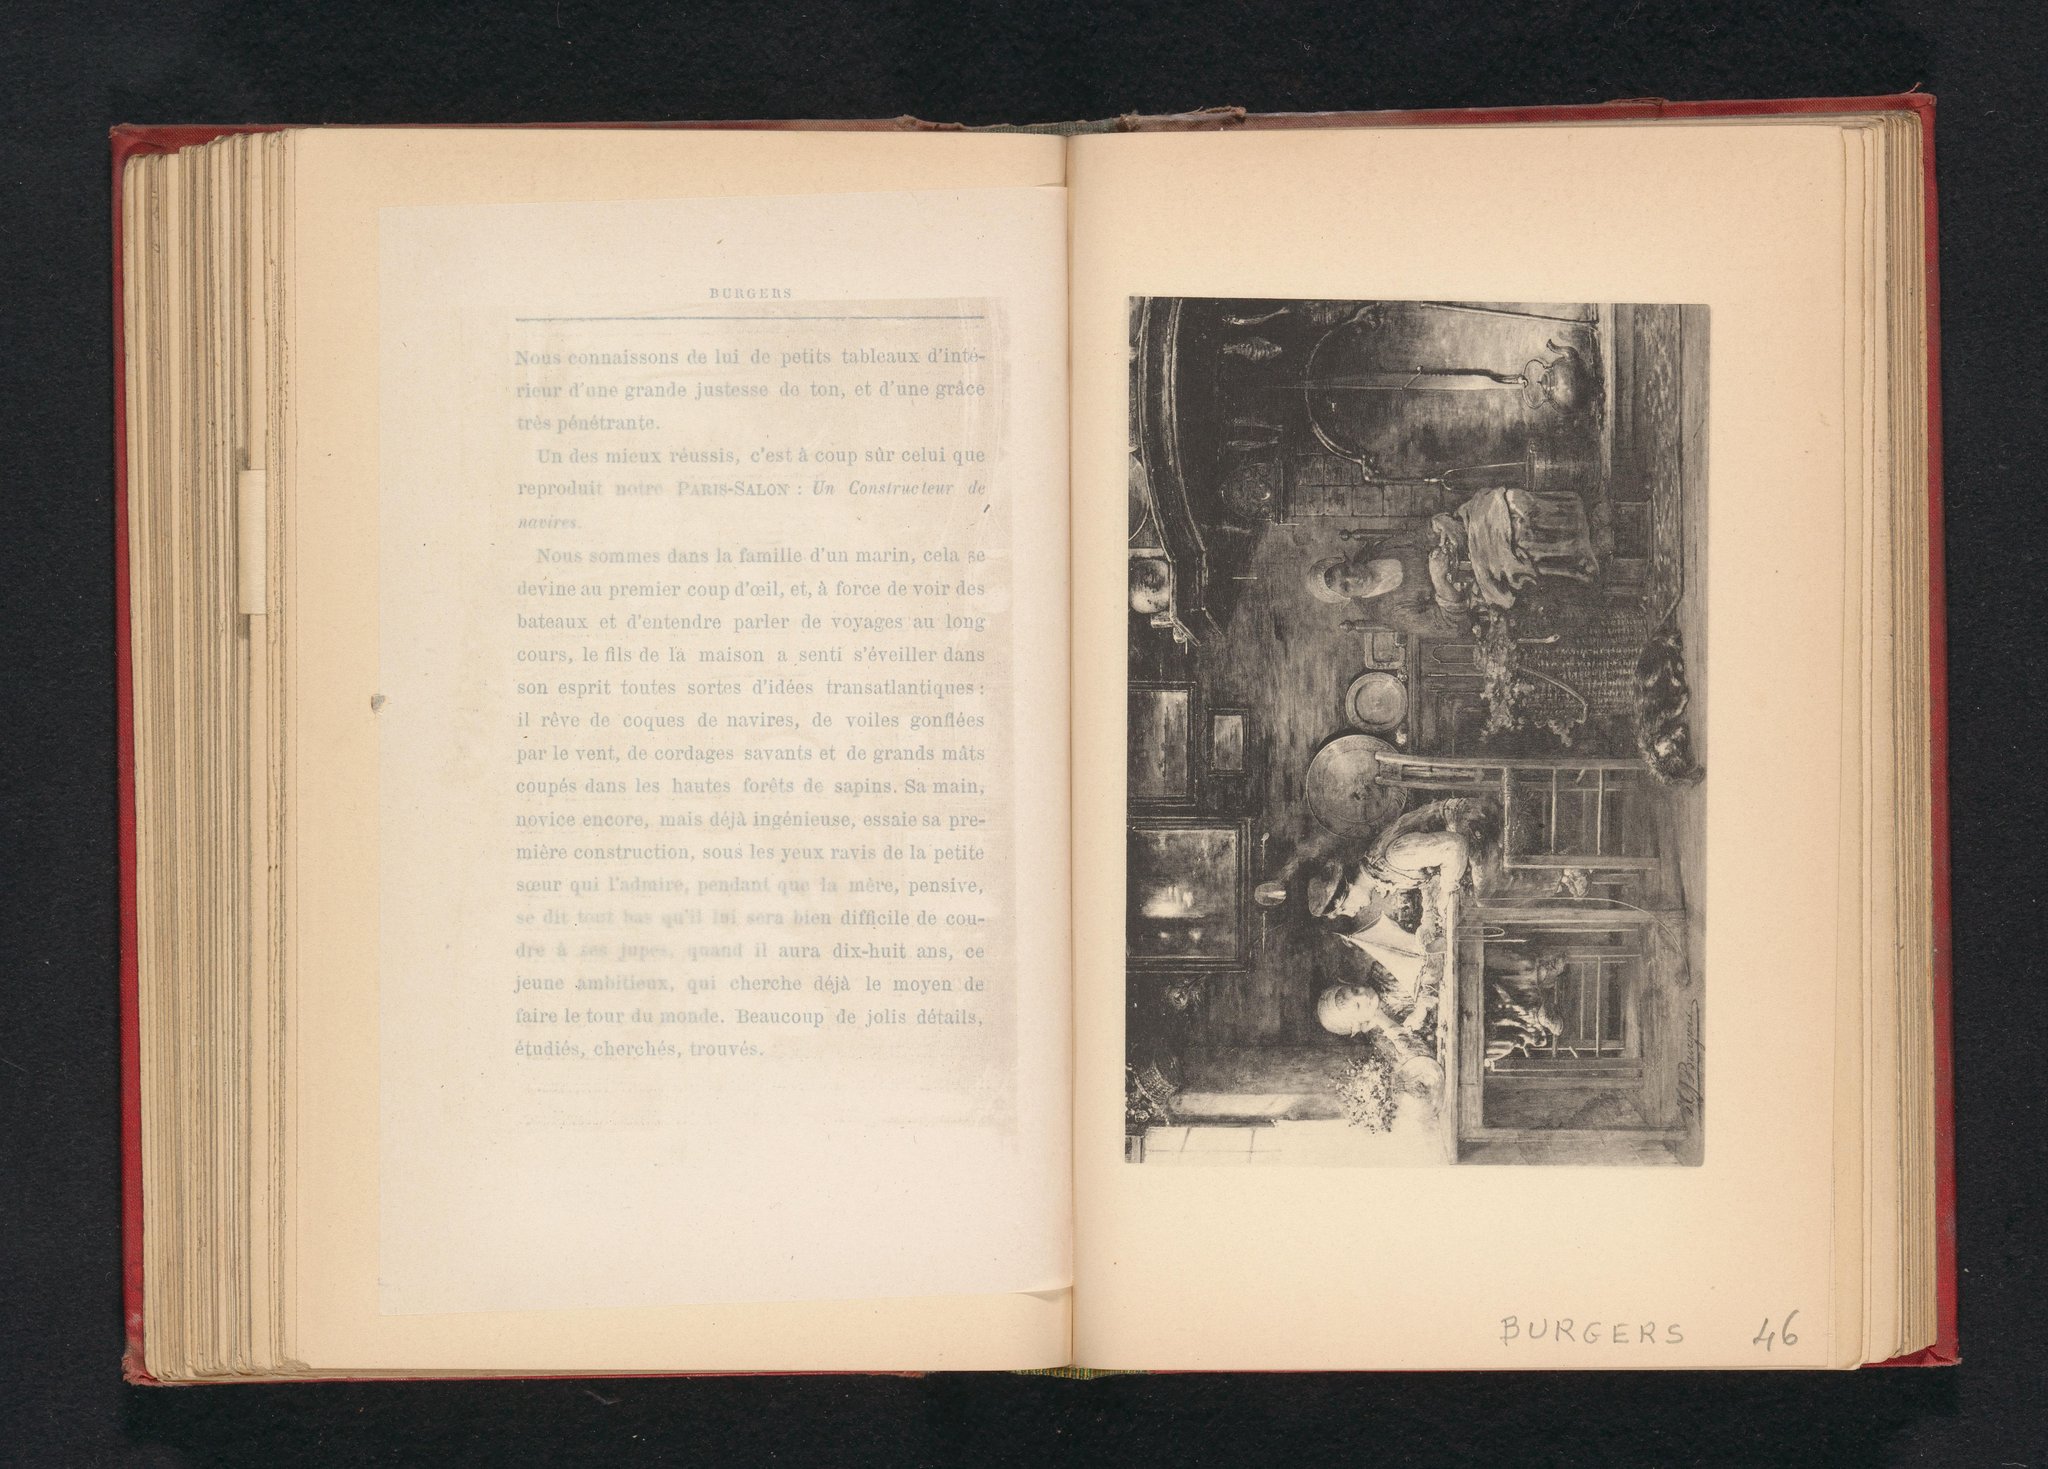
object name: photomechanical print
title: Fotoreproductie van een schilderij, voorstellende een interieur met twee kinderen aan tafel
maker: hein burgers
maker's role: painter, print maker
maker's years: 1834-1899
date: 1872-1882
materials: paper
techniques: photograph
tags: (other forms of) needlework, e.g.: crocheting, knitting, embroidering, living-room, parlour, sitting-room, child (at home), sculpture (+ relief ~ sculpture)